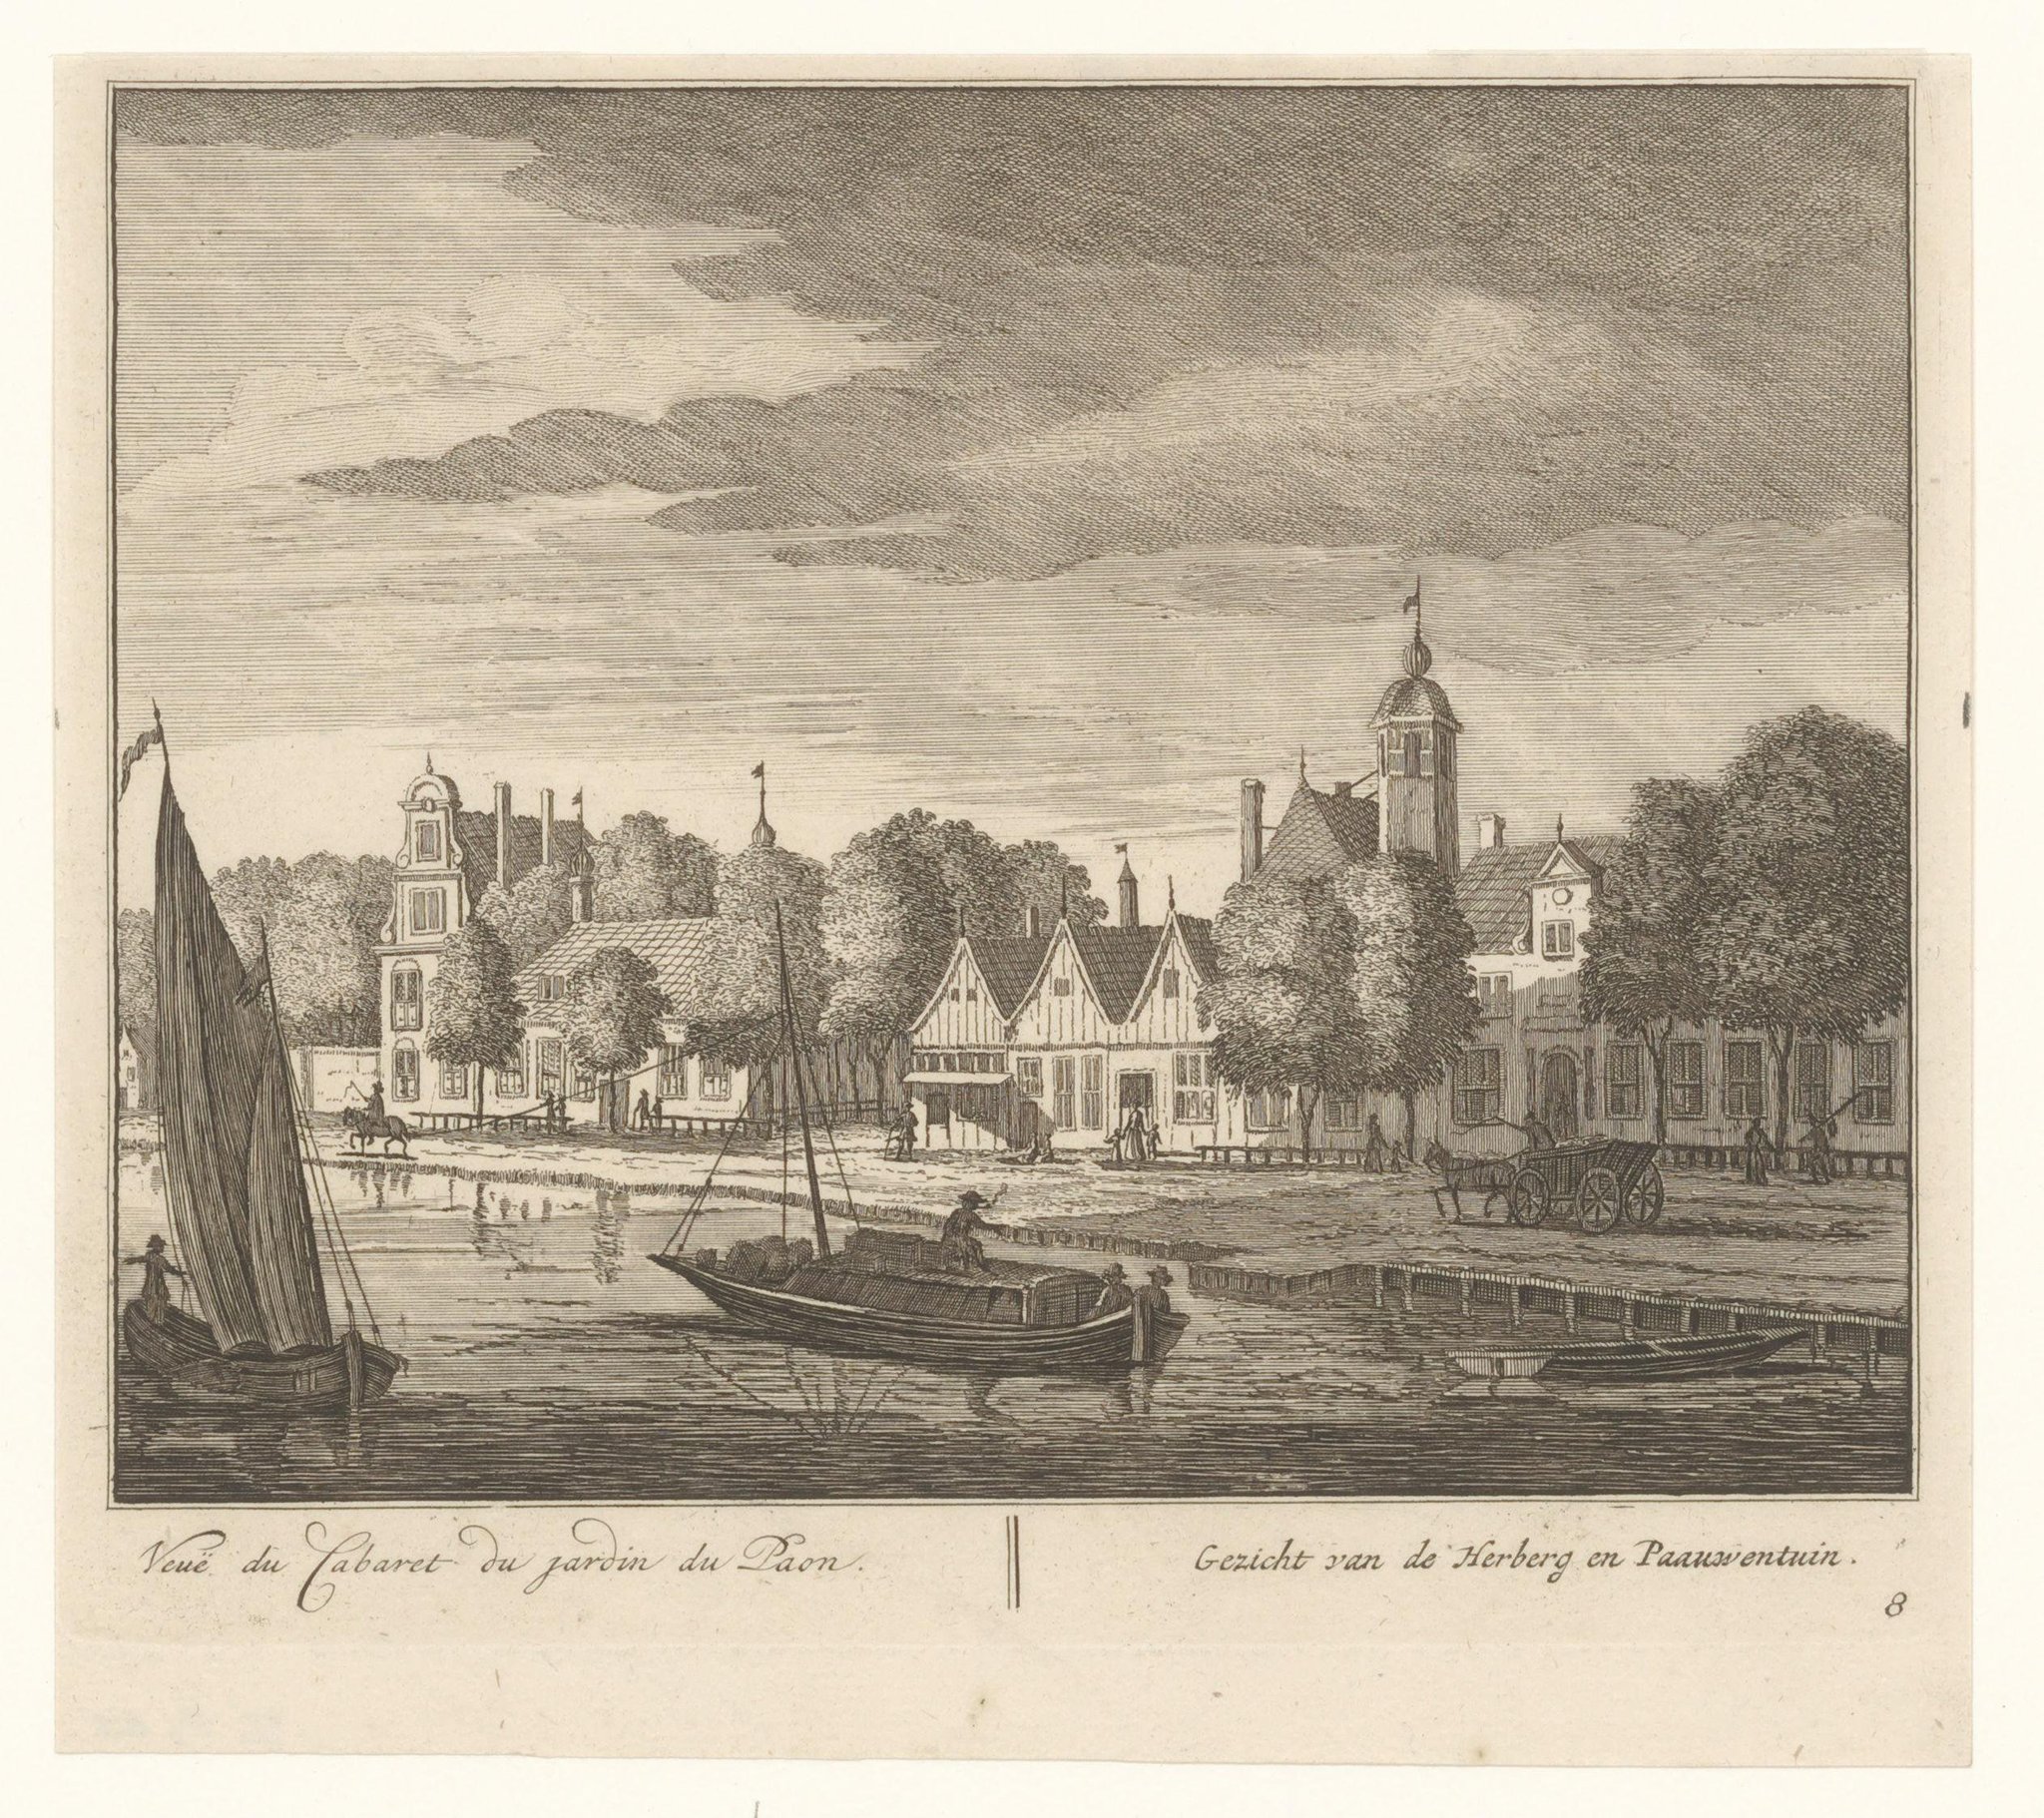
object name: print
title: Hollands Arcadia, of de vermaarde rivier den Amstel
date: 1730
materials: paper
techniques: etching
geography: amsterdam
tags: city-view in general; 'veduta', river, hotel, hostelry, inn, boat propelled by man or animal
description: Prent waarschijnlijk uit: Tijsens, Gijsbert. Hollands Arcadia, of de vermaarde rivier den Amstel (...) naar 't léven getekend en in 't ligt gebragt door Abraham Rademaker (...). Amsterdam: Leonardus Schenk, 1730.